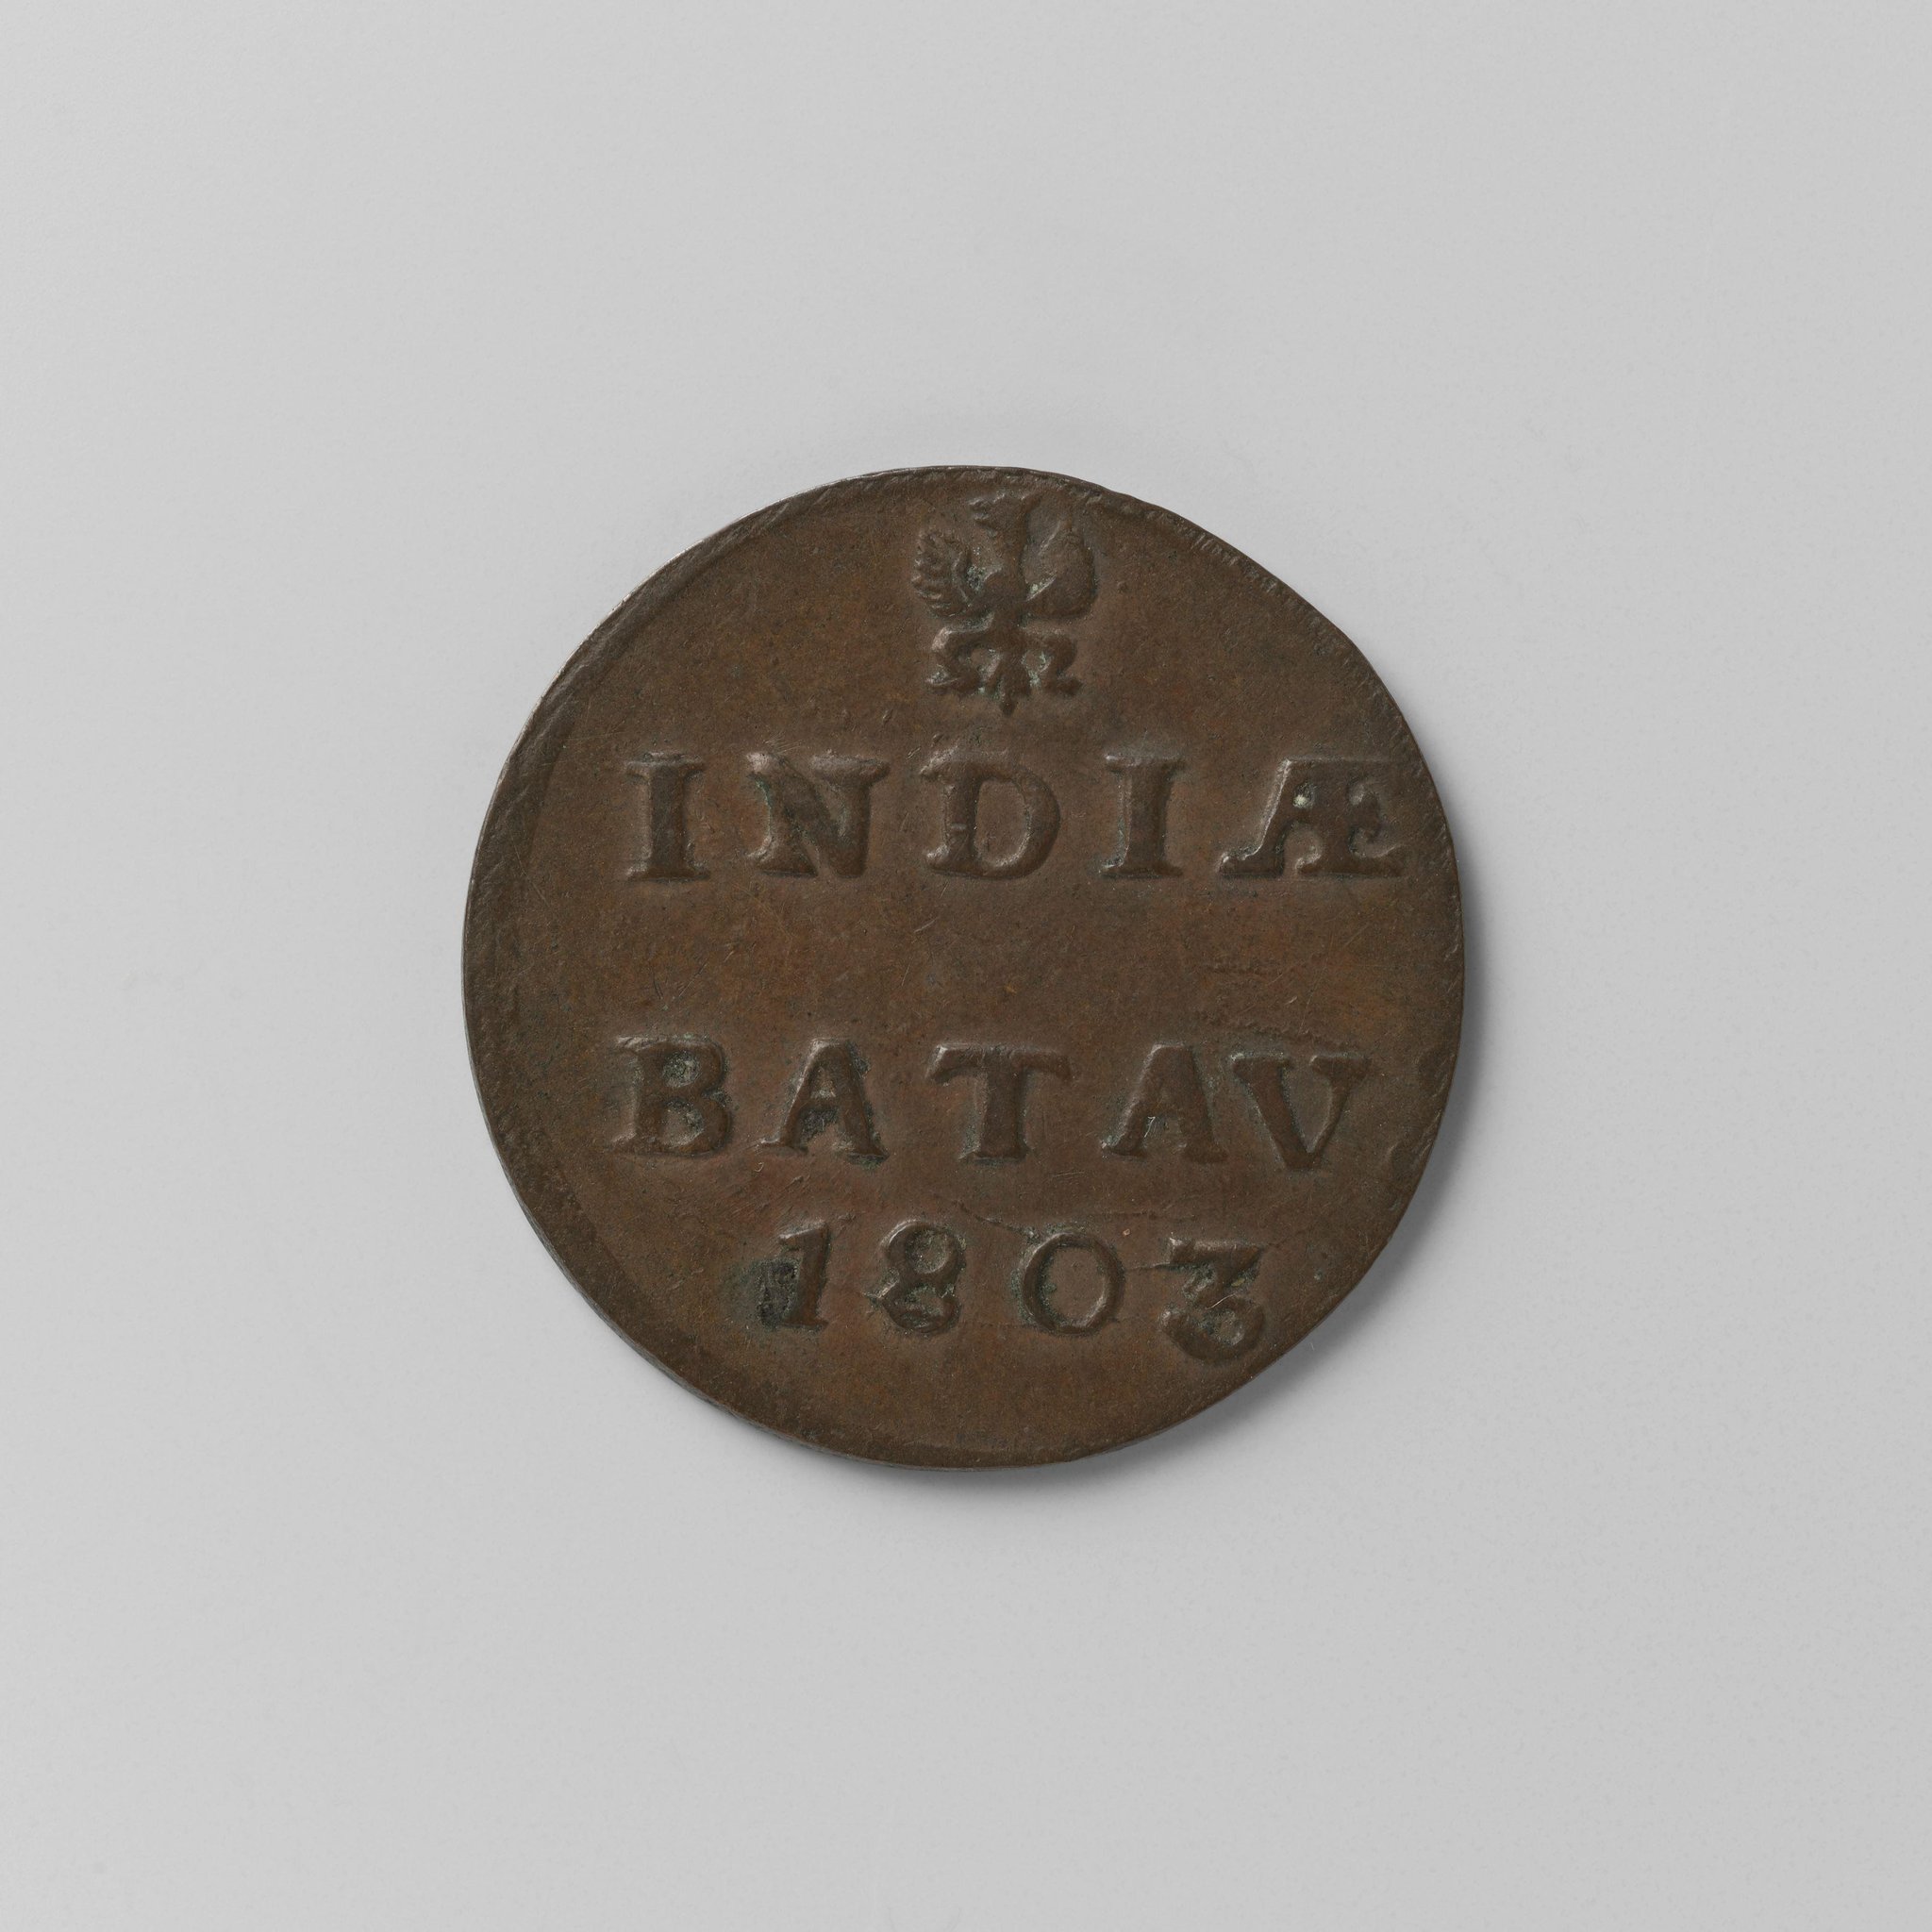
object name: coin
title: Nederlands Indië, duit Overijssel,1803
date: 1803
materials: copper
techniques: striking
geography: kampen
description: Koperen munt. Voorzijde: tweeregelig opschrift, waarboven muntmeesterteken en waaronder jaartal. Keerzijde: binnen wpenspreuk tussen waarde-aanduiding 5 1/16 G gekroond wapenschild van Overijssel. Gladde rand.